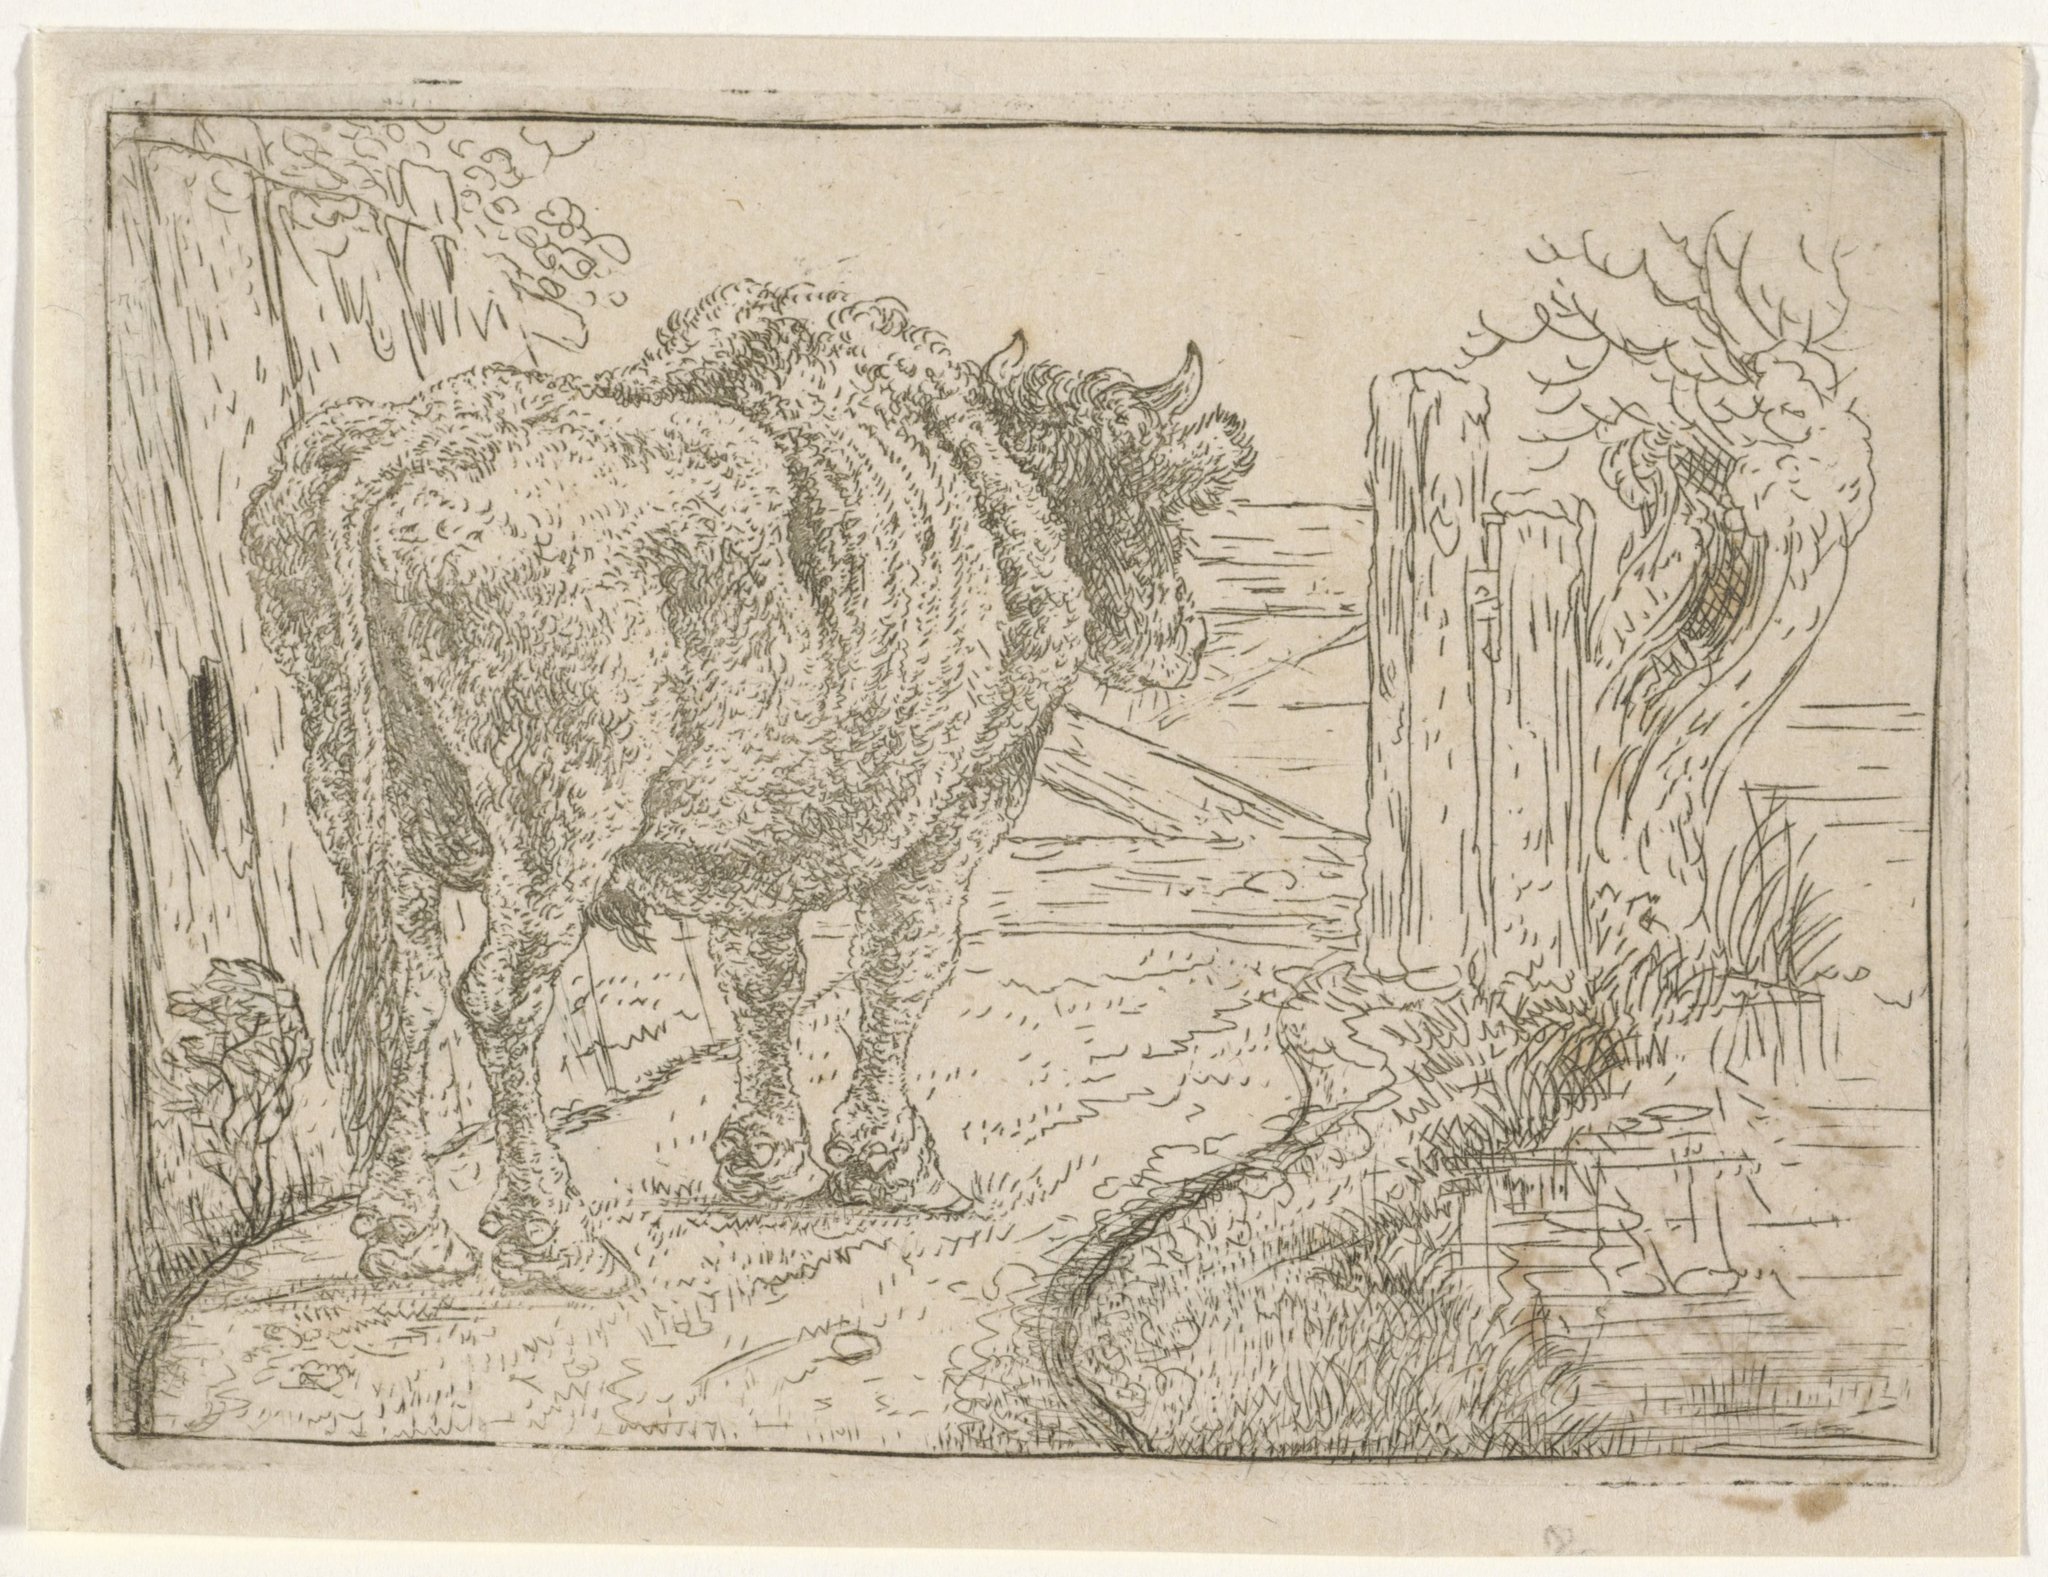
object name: print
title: Staande stier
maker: jan jansz. den uyl (ii)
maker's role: draughtsman, print maker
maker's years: 1621-1669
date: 1632-1679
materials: paper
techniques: drypoint, etching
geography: northern netherlands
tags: bull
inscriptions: collector's mark: Lugt 240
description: Staande stier, van achteren gezien, naast een beek en bij een hek en een knotwilg.